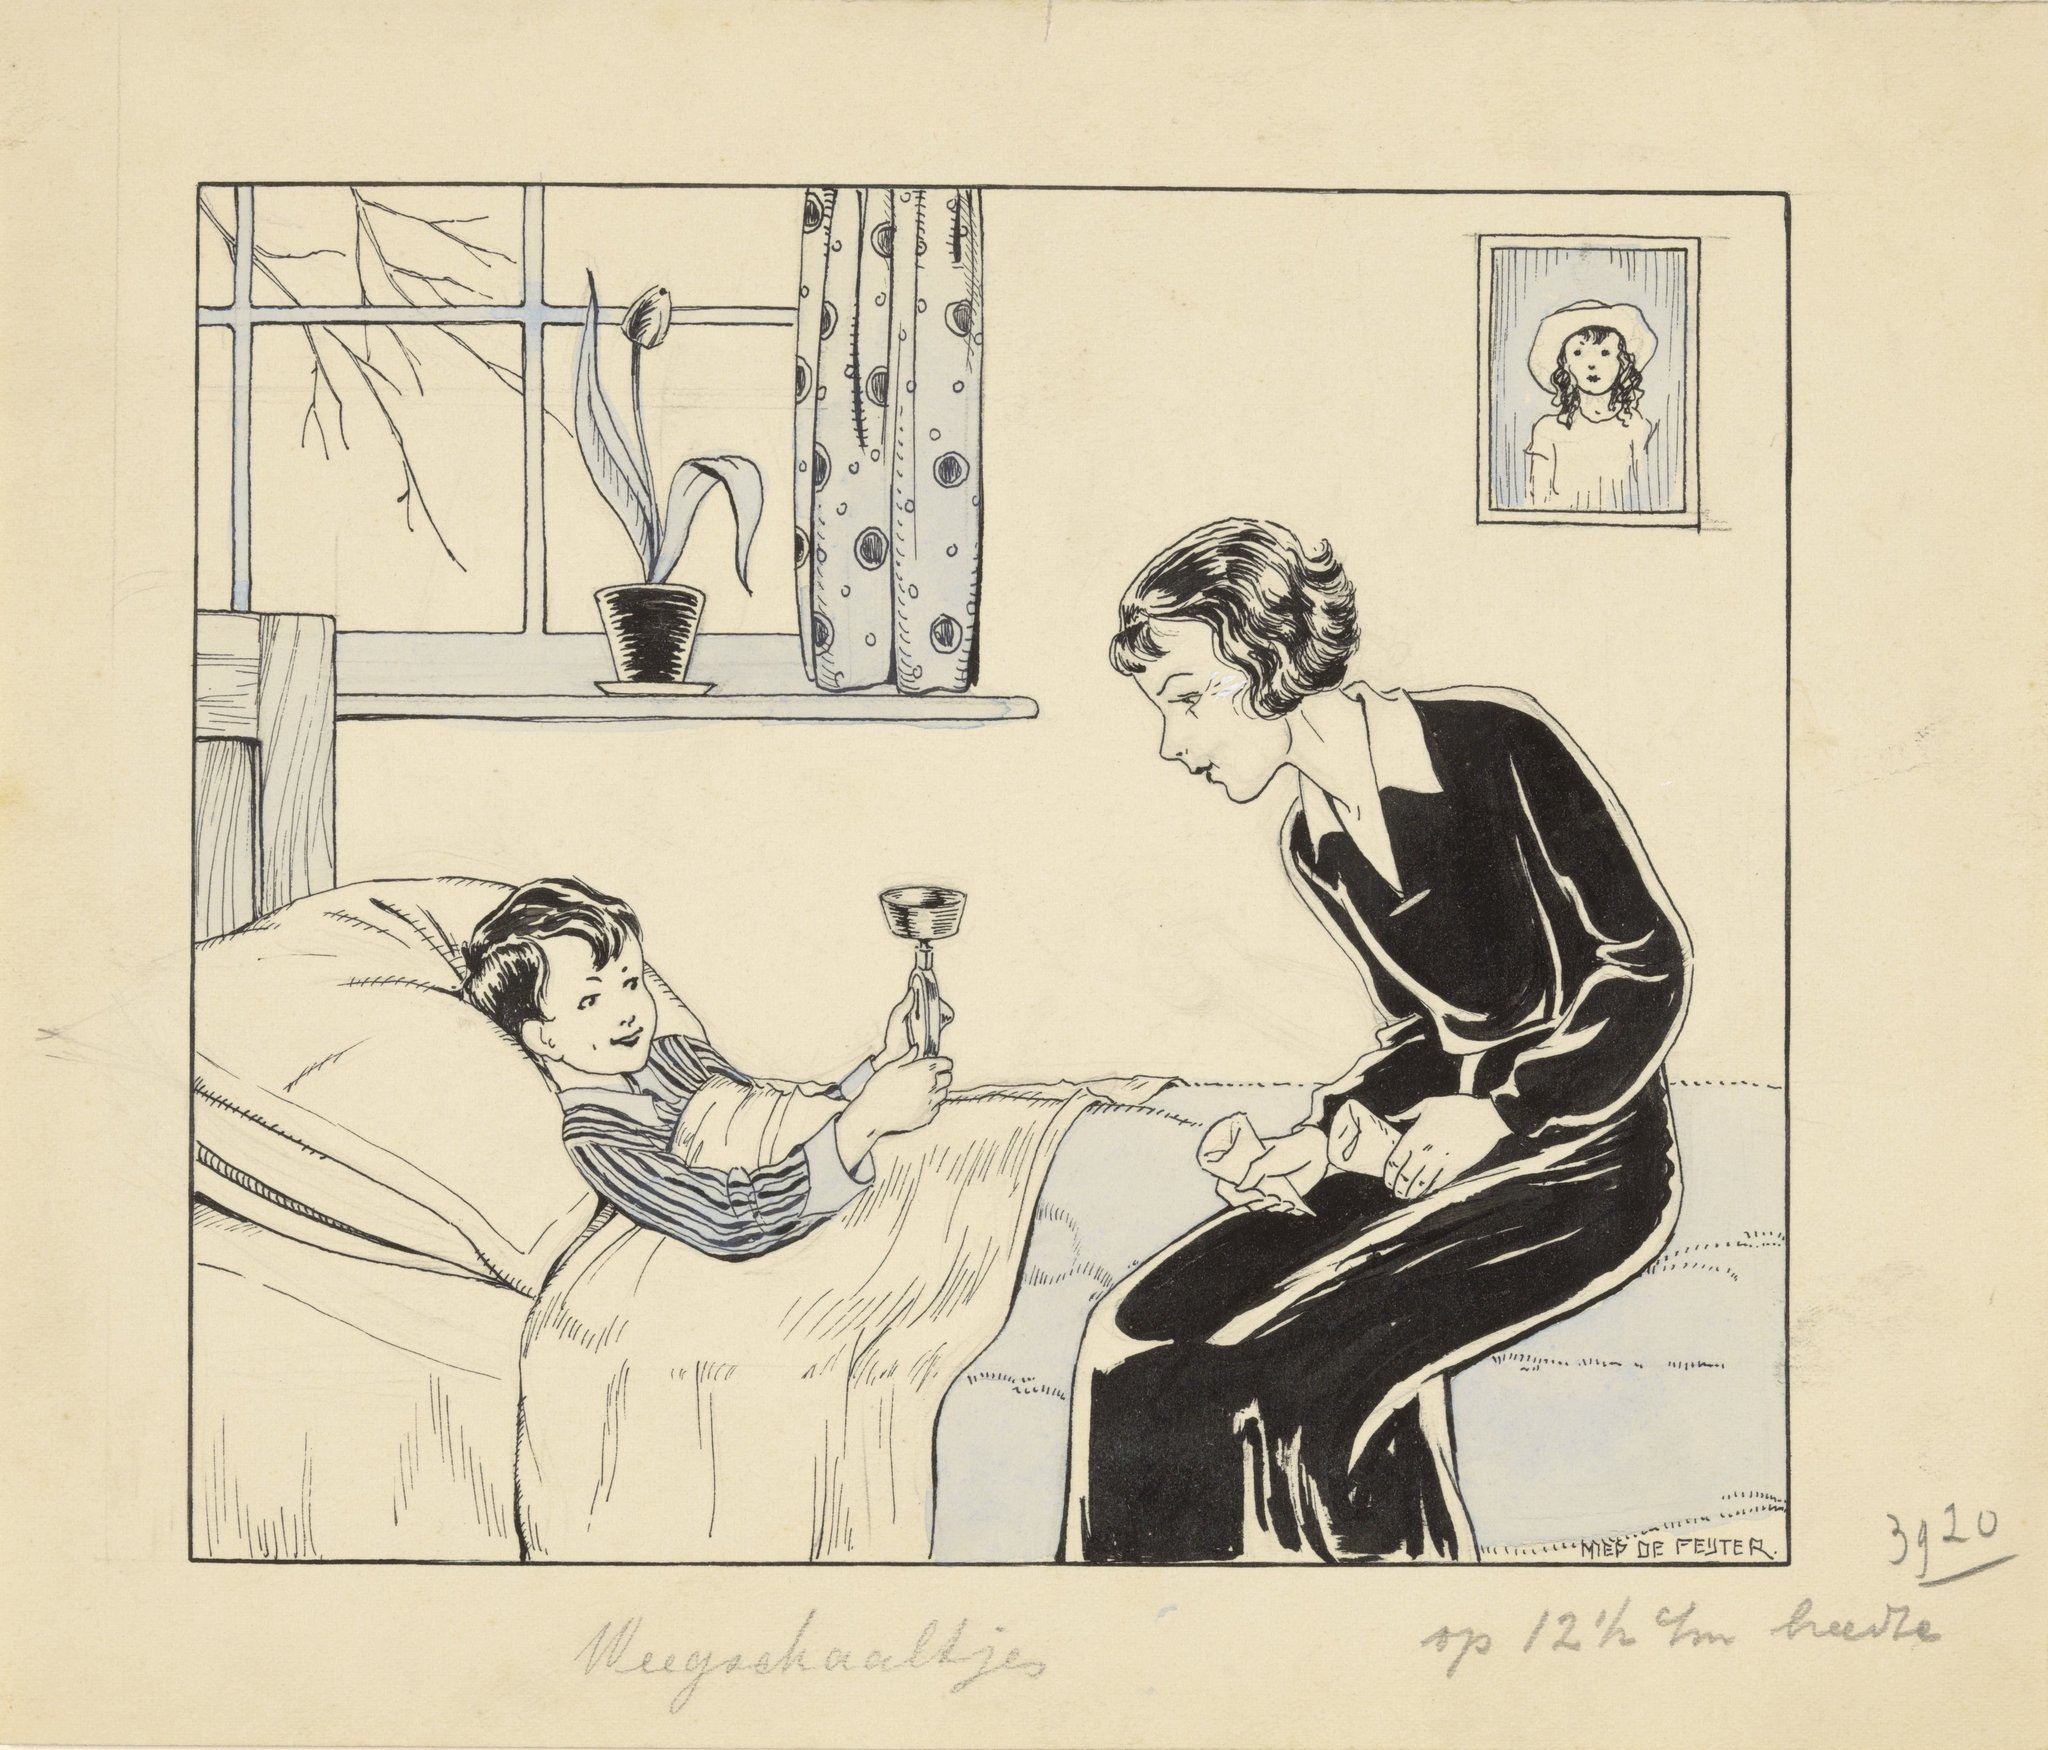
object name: drawing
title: Jongen met weegschaal in een bed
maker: miep de feijter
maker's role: draughtsman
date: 1928-1941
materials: ink, paper, pencil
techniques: brush, pen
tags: sick-bed, boy (child between toddler and youth), scales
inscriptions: annotation: ‘Weegschaaltjes’, signature: ‘MIEP DE FEIJTER.’, collector's mark: Lugt 2228a, :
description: Een jongen ligt in pyjama op bed bij een venster. In zijn handen houdt hij een weegschaal. Op het bed zit een vrouw die twee pakketjes in de vorm van hoorntjes in haar handen heeft.